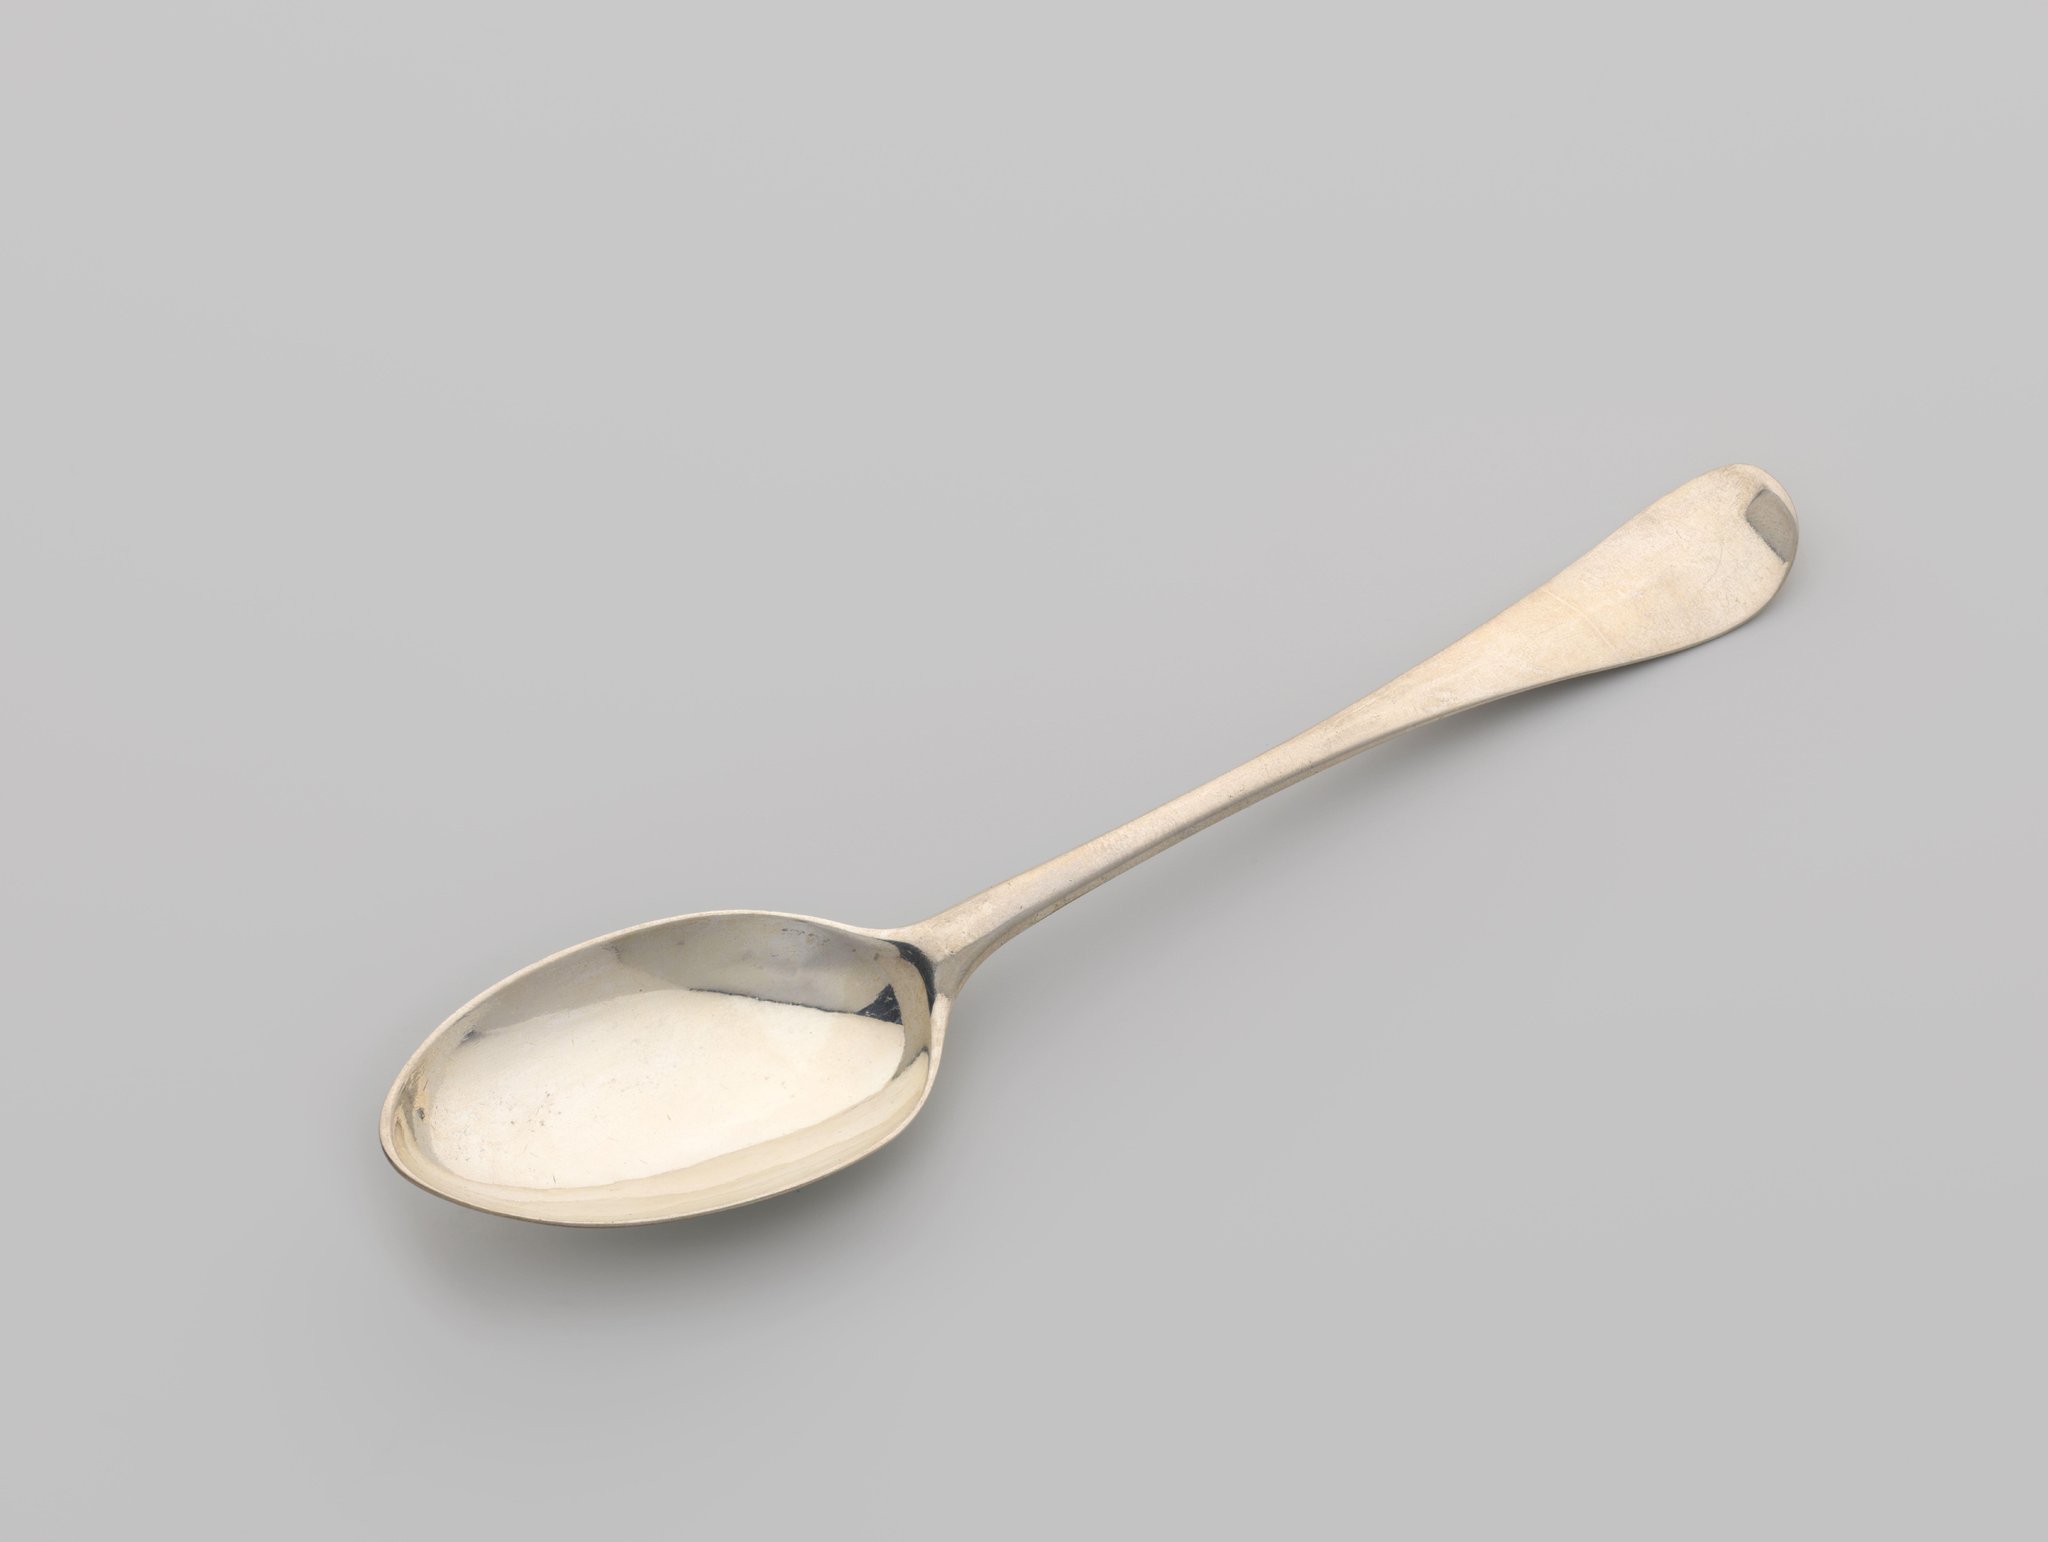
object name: dessert spoon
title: Dessertlepel met het helmteken Clifford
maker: cornelis loeff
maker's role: silversmith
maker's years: 1738-1793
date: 1793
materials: silver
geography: amsterdam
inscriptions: date letter: ‘I’, town mark, maker's mark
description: De eivormige bak is door middel van enkel lof verbonden met de platte, gebogen steel, die zich verbreedt naar het afgeronde uiteinde en die aan de bovenzijde over het midden een flauwe ribbel vertoont. Op de onderzijde van de steel is het helmteken Clifford gegraveerd.